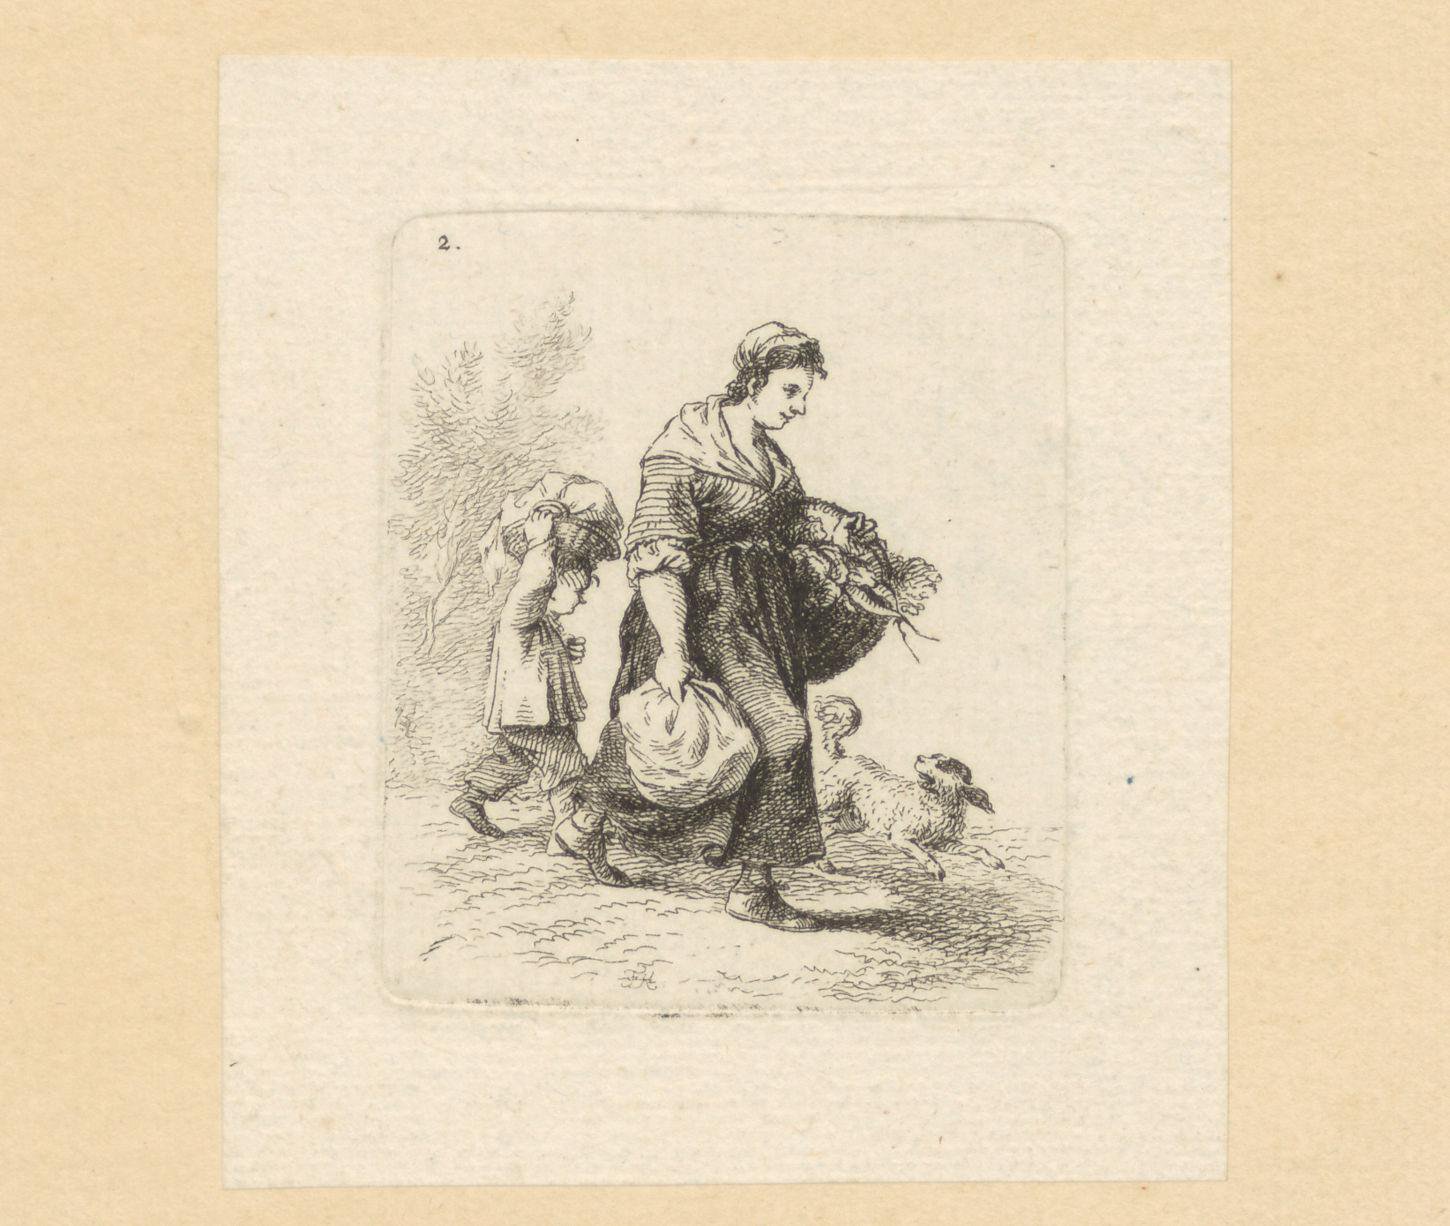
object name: print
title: Moeder en kind met boodschappen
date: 1770-1780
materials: paper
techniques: etching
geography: paris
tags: mother and baby or young child, marketing, shopping (~ household management)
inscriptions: number: ‘2’, collector's mark: Lugt 2228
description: Deze prent hoort bij een serie van vijf prenten getiteld 'Etudes d'apres nature' door Ferdinand Kobell gemaakt tussen 1770 en 1775 en zijn uitgegeven in Frankrijk door Gottlieb Hess.